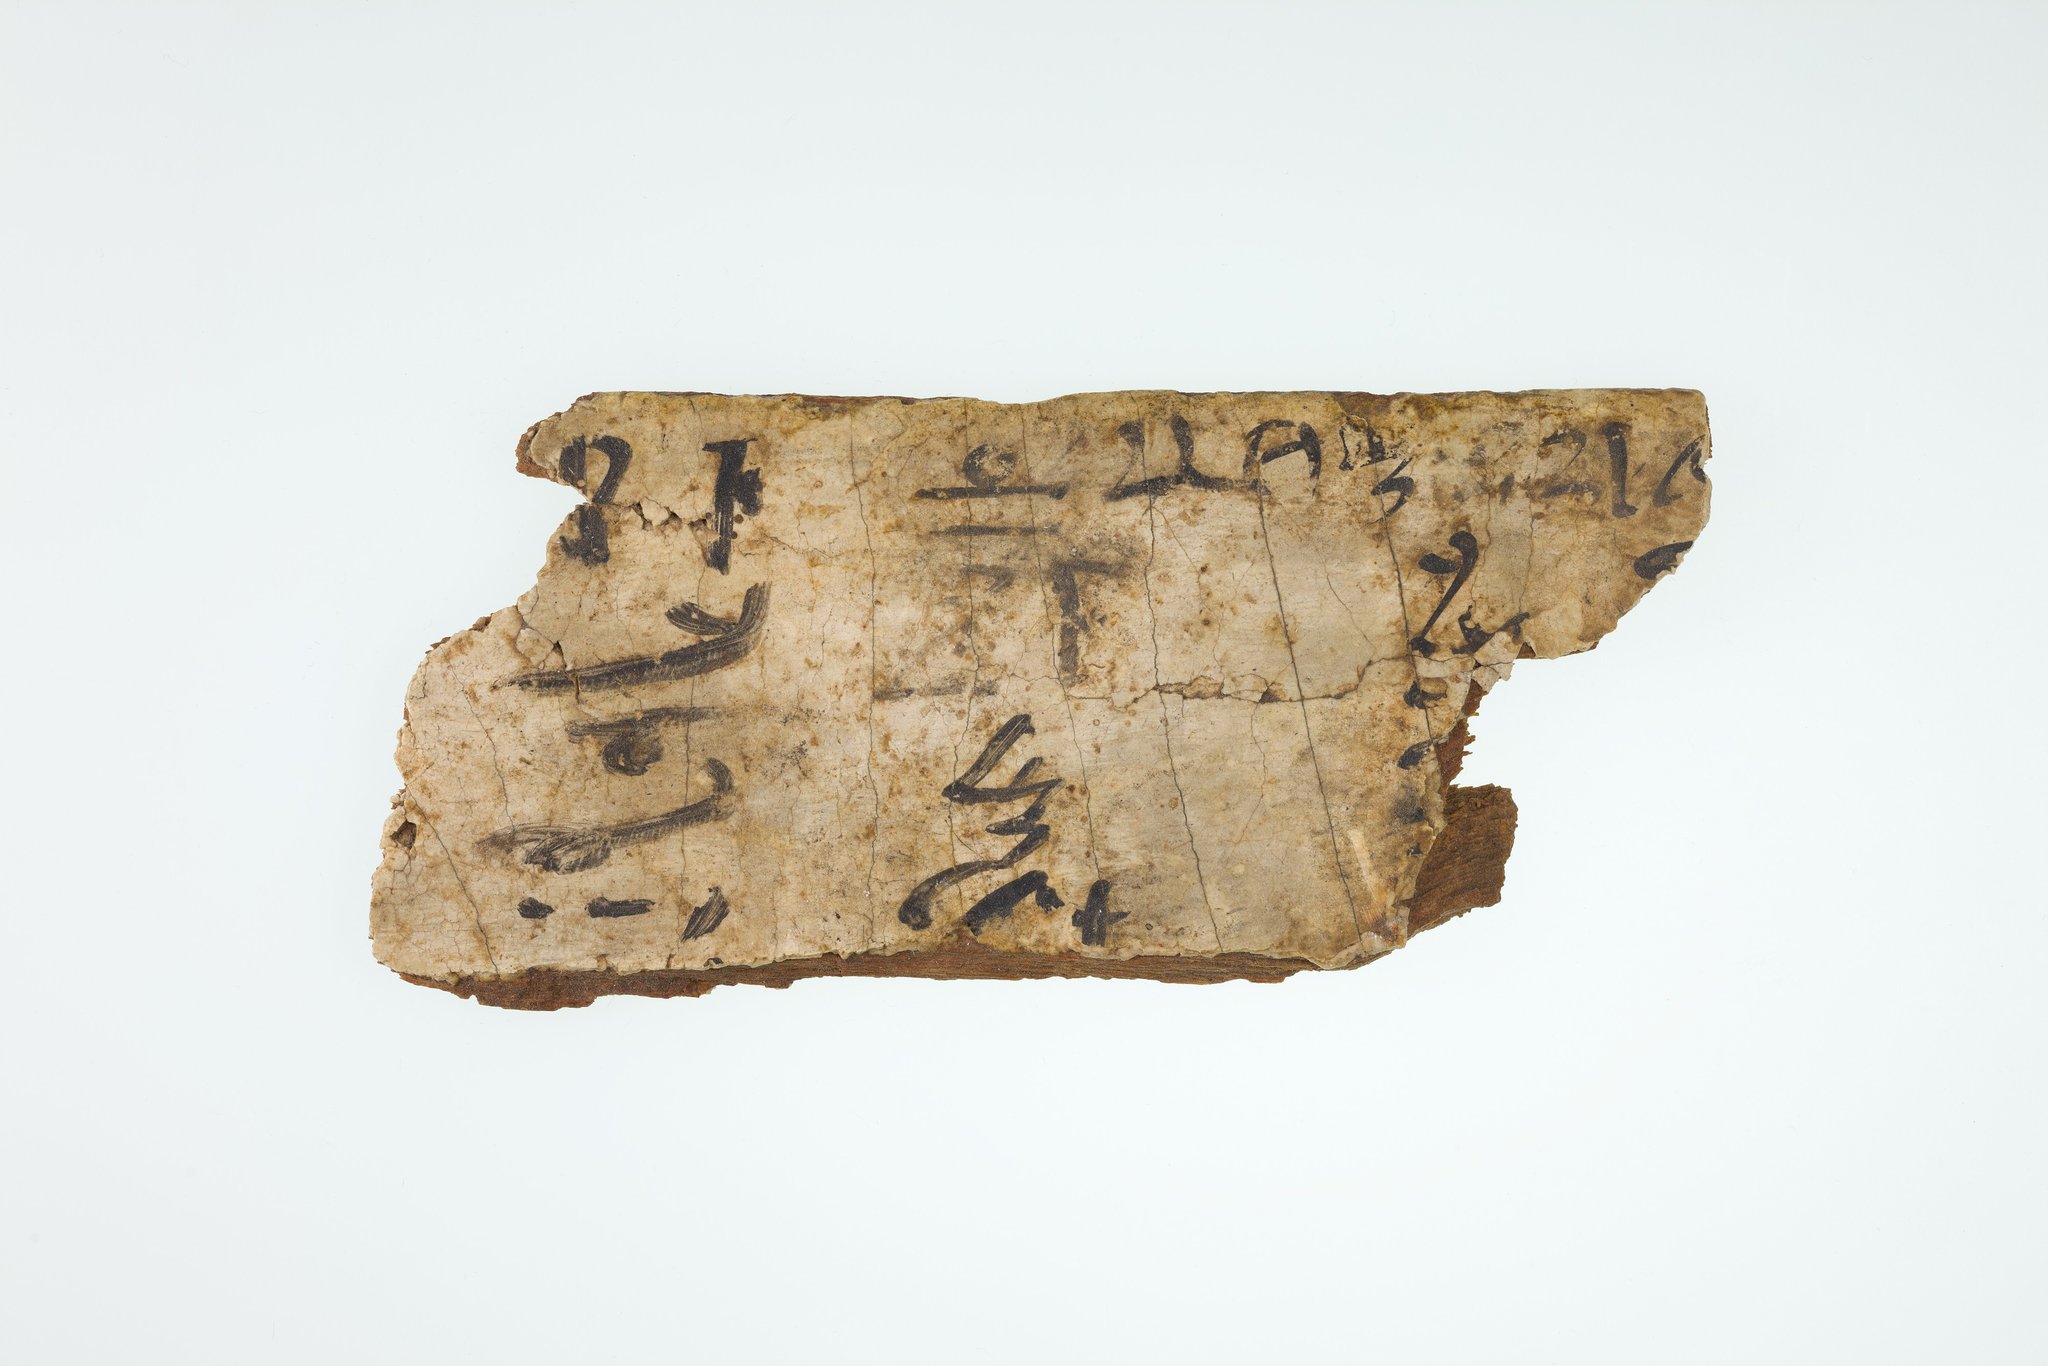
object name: writing board fragment, scribe's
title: Fragments from a Scribe's Writing Board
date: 2130-1981 BCE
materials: gesso, wood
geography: egypt